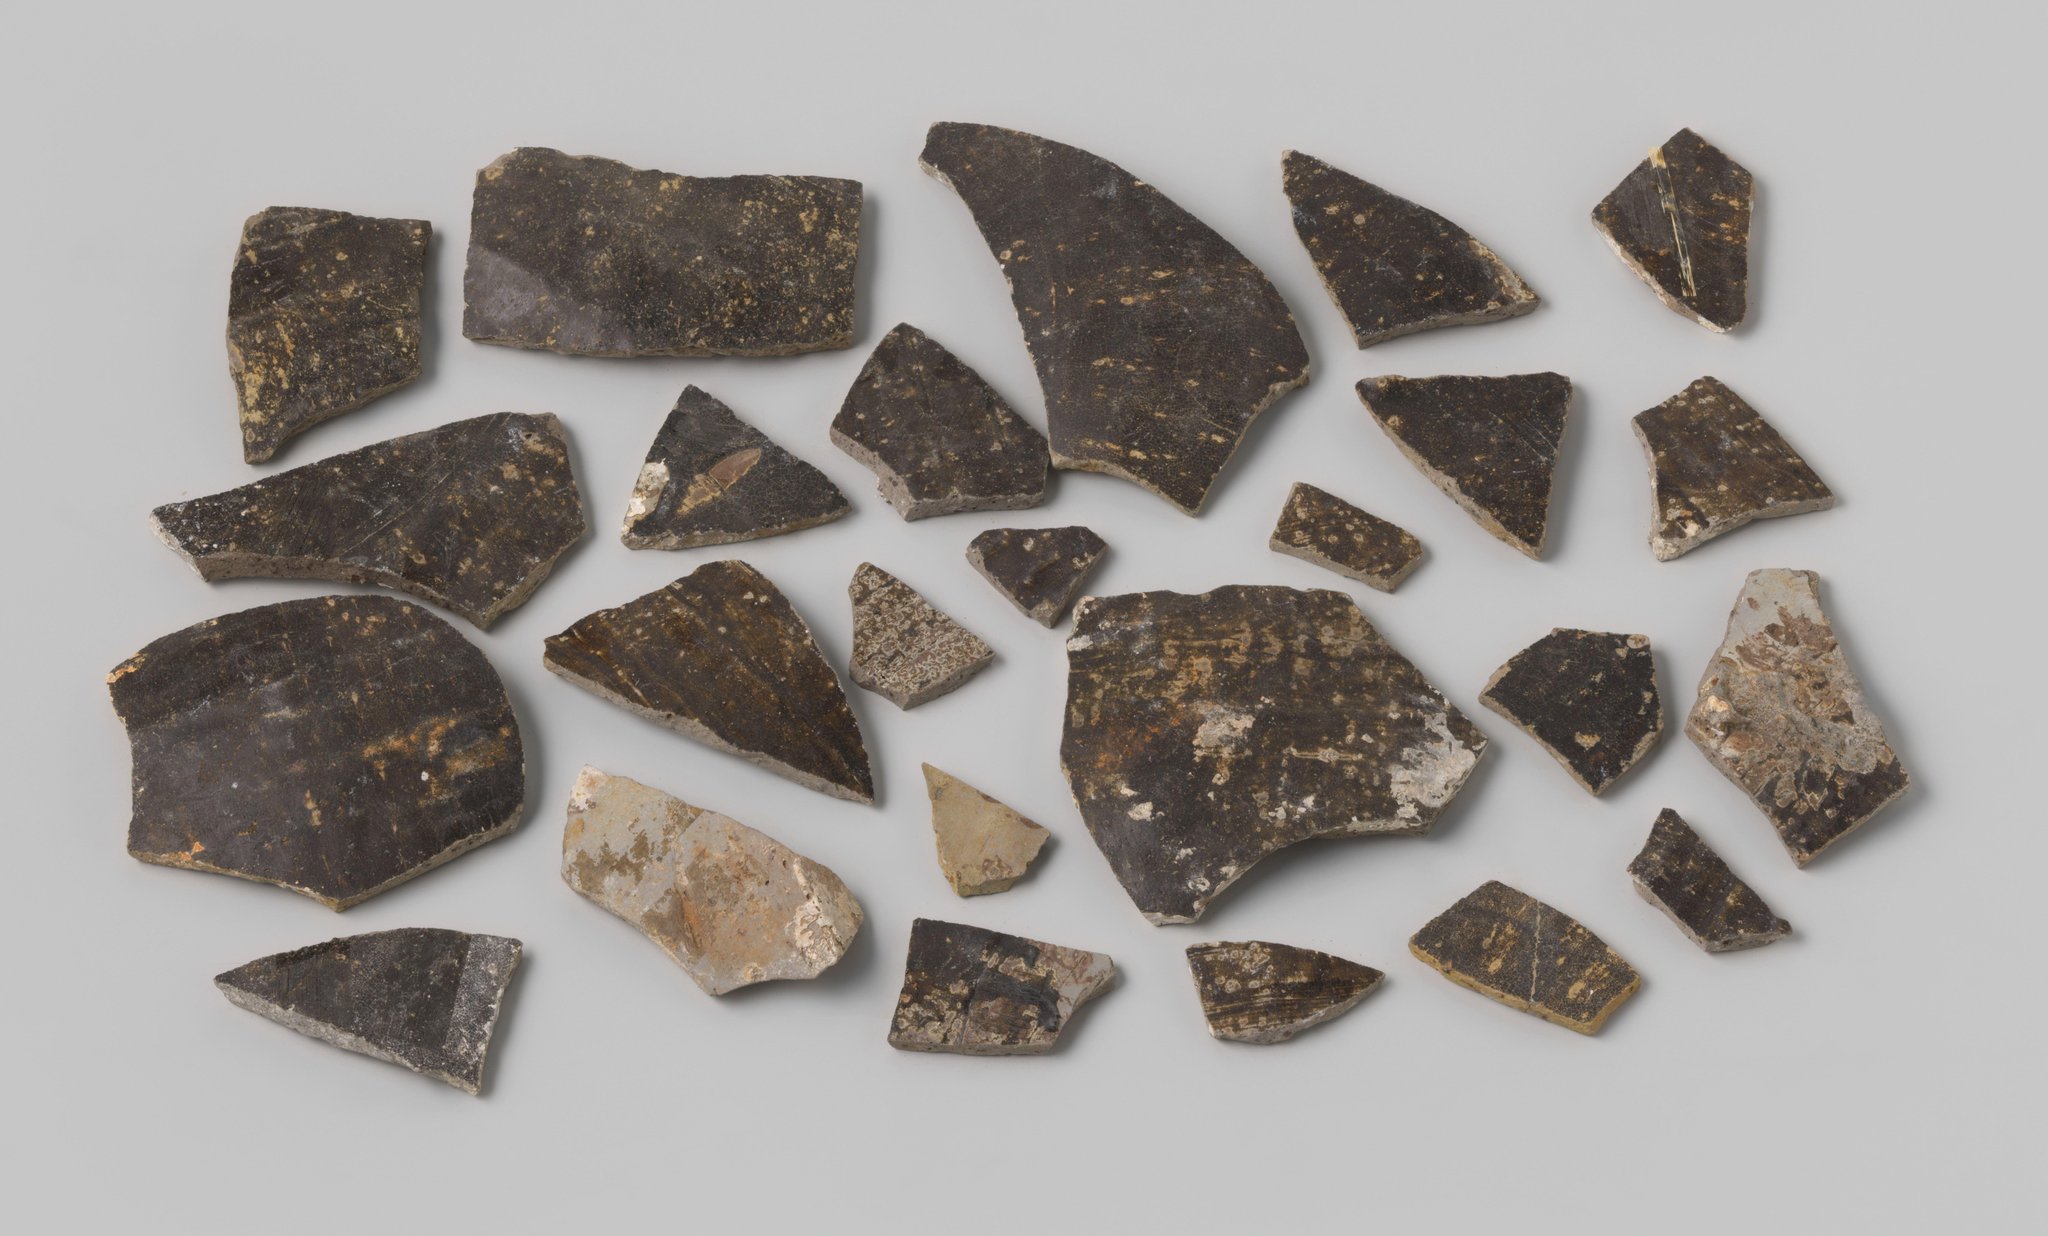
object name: martavaan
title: Scherven van martavanen uit V.O.C.-schip de 'Witte Leeuw'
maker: Anonymous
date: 1613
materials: porcelain, stoneware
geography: martaban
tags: verenigde oostindische compagnie, sint-helena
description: A jar. The upper part of the jar is glazed and long trickles run down. On the inside, the lip, neck and shoulders joint are glazed. Between the neck and shoulder, there is an unbroken dotted band. From this band vertical bands run down halfway the body. The jar has been made in two parts, of which the lower part is smaller.